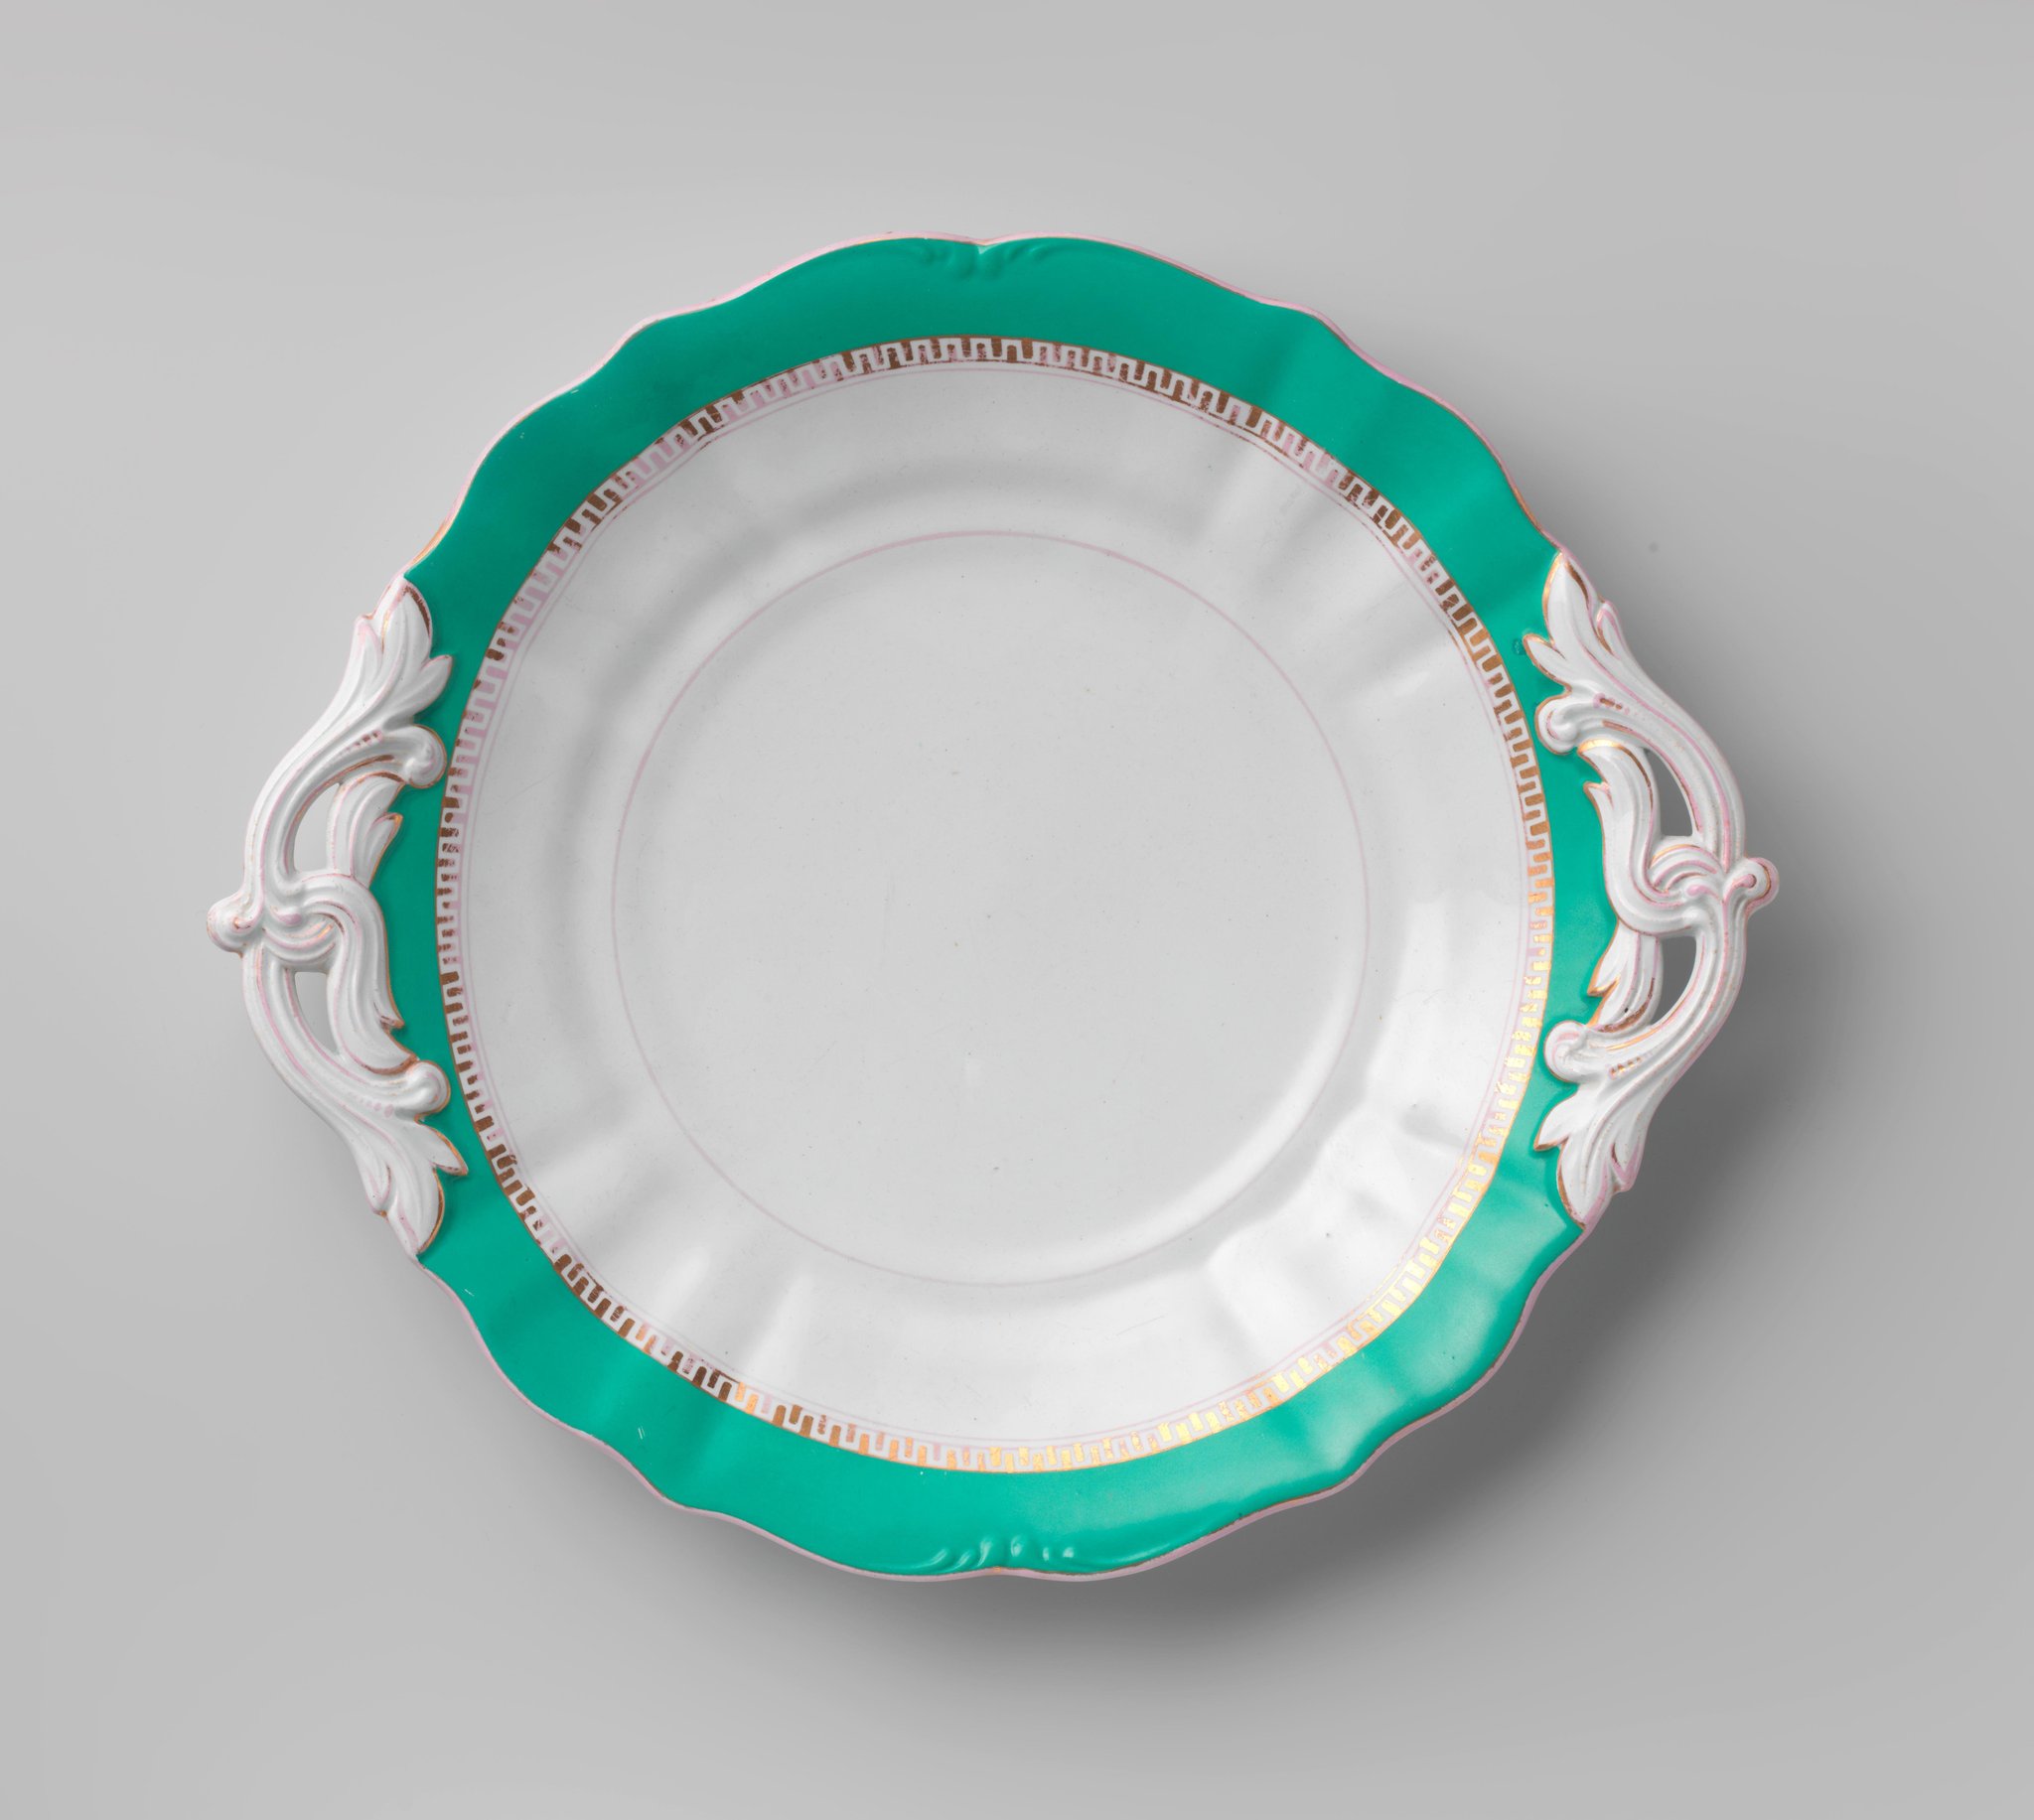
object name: dish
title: Schaal, rond, met groene rand en gouden Griekse band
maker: petrus regout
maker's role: plateelbakker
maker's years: 1801-1879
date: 1865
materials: earthenware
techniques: transfer decoration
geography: maastricht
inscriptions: check stamp: ‘P. REGOUT // MAASTRICHT // 2X 9.’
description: Schaal van aardewerk, rond, geschulpt, met groene rand en gouden Griekse band. De schaal heeft twee oren.